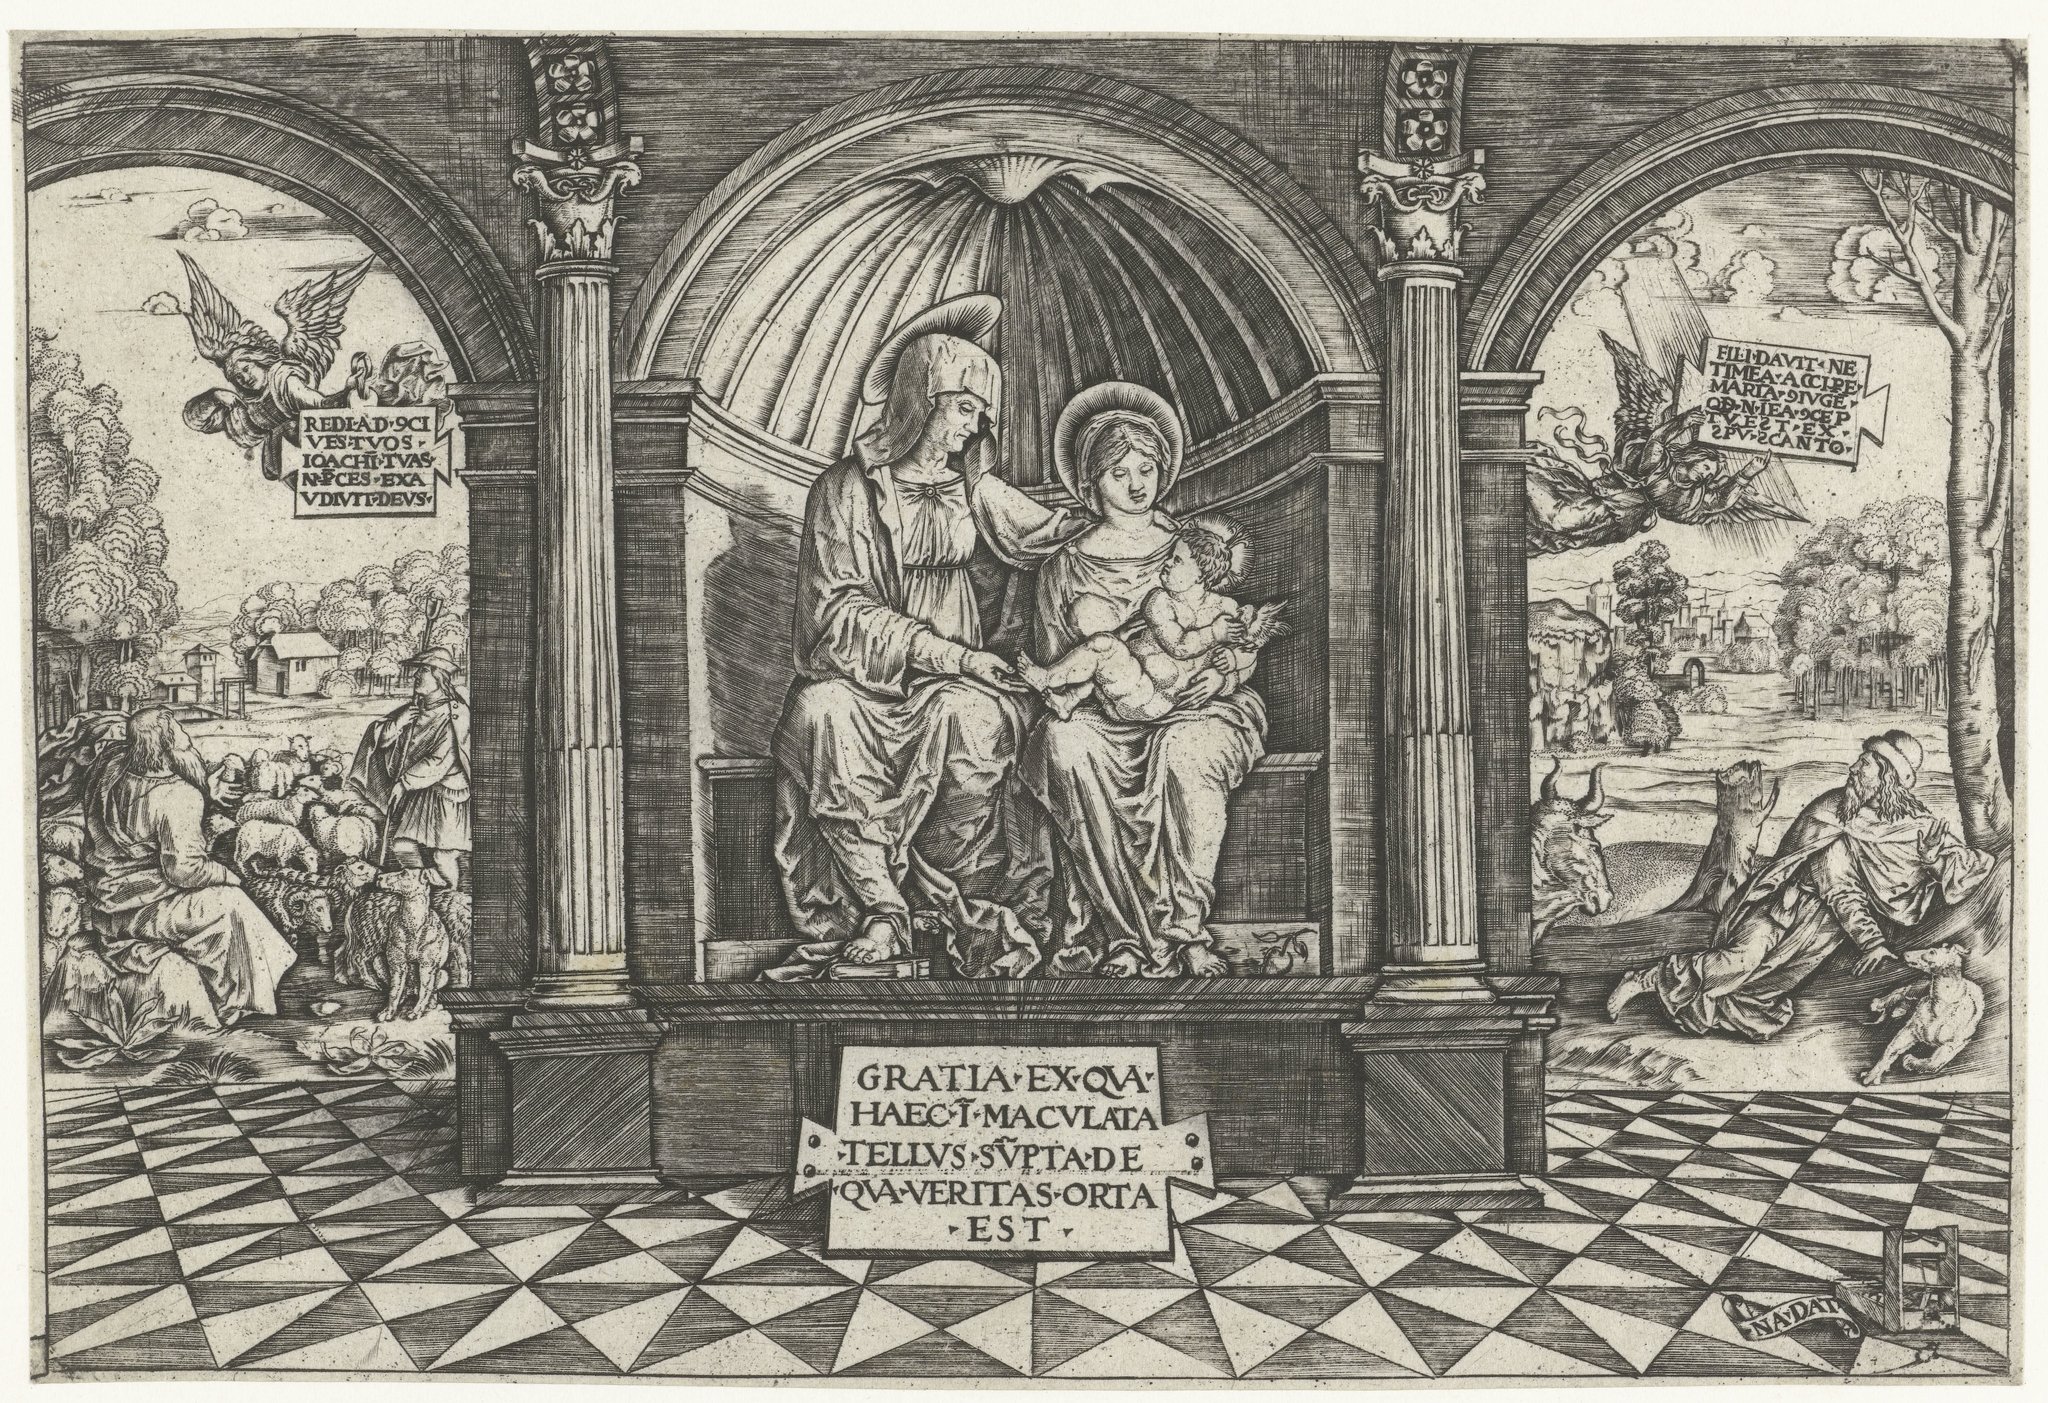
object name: print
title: Anna te Drieën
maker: meester nadat met de muizenval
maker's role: print maker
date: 1512-1520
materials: paper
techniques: engraving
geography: rome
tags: annunciation of christ's birth to the shepherds (and/or shepherdesses) at night; a host of singing angels in the air, 'anna selbdritt', i.e. anna, mary and christ-child close together, annunciation of the birth of mary to joachim by an angel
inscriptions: collector's mark: Lugt 2760, collector's mark: Lugt 2228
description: Watermerk: Weegschaal in cirkel met ster. Vergelijk veiling Sotheby's 20.3.1973 (Collectie Richard & Elis. Bull). Prent was geplakt in Engelse bijbel, vergelijk Sotheby, 1973-08-03, nr. 1.